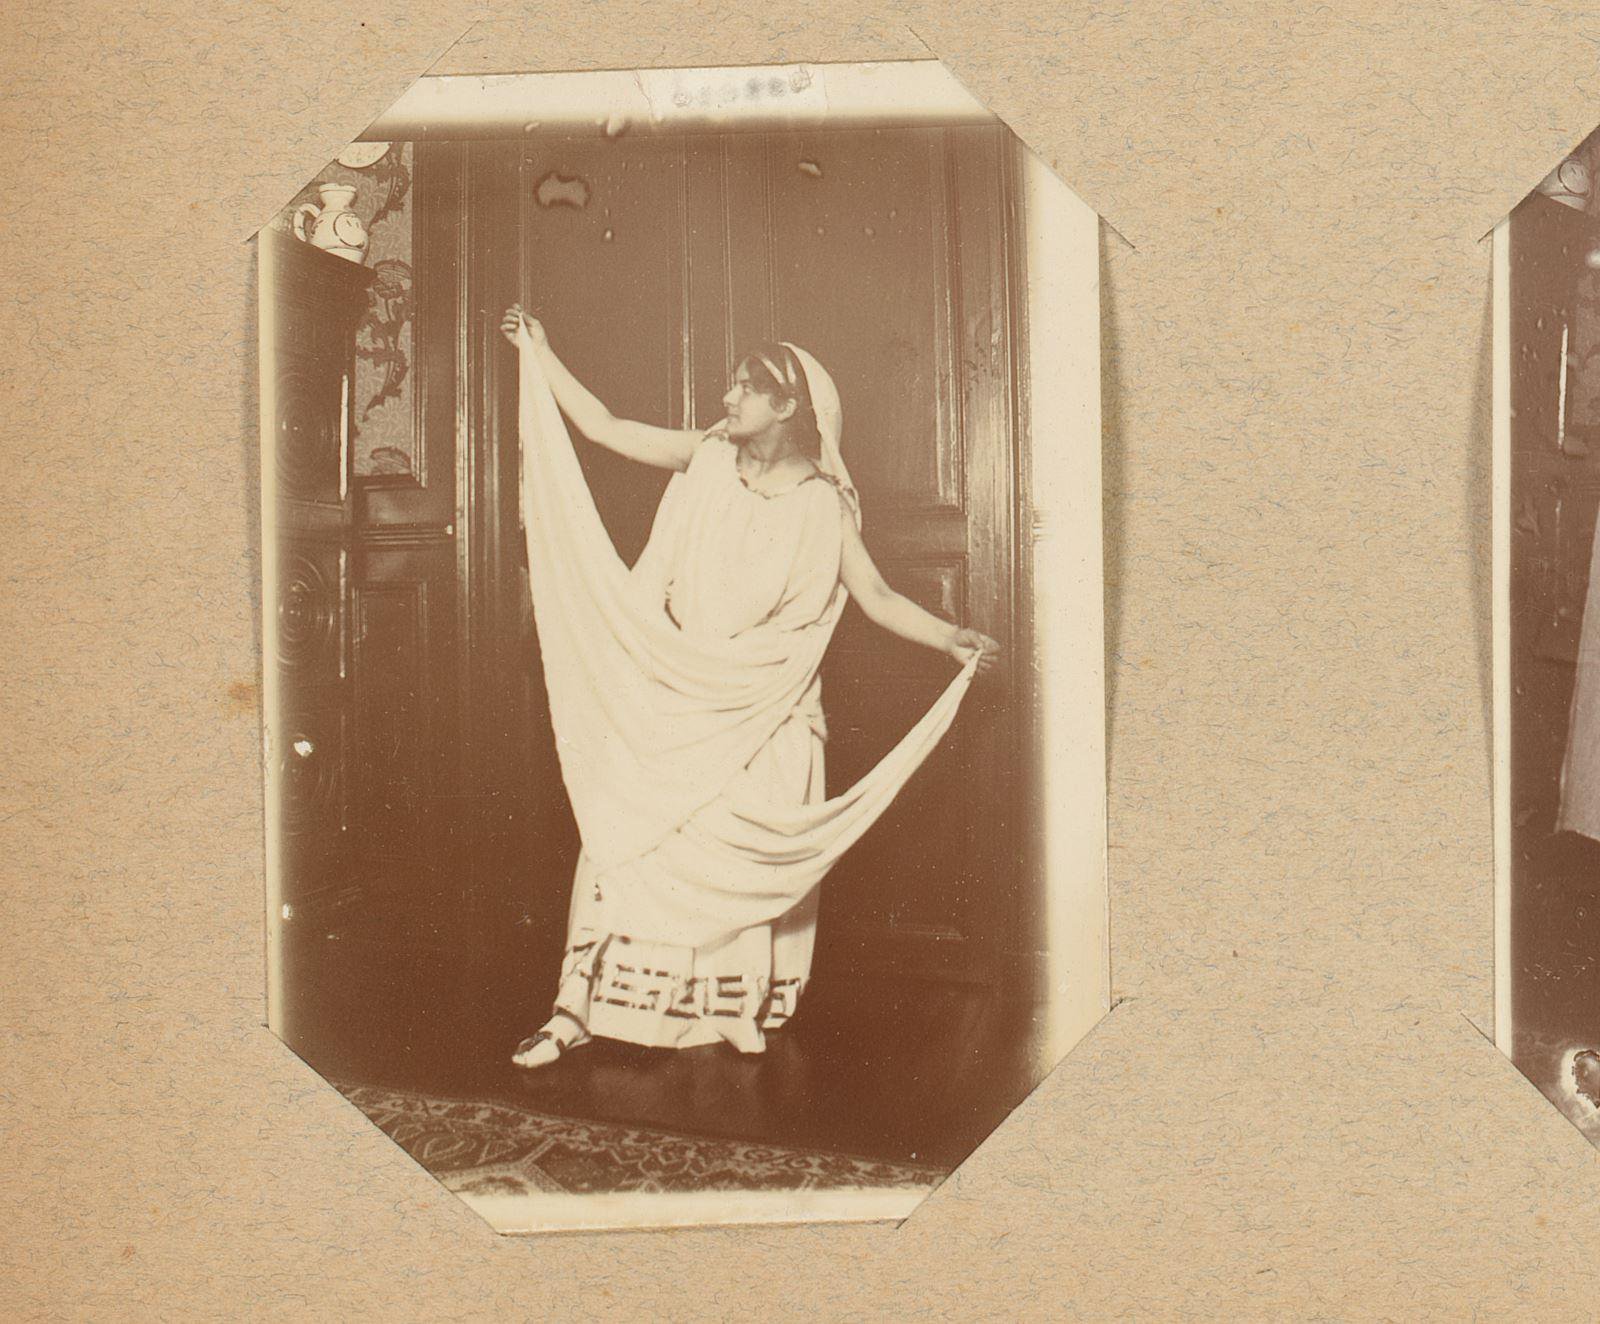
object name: photograph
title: Portret van een vrouw in verkleedkleding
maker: Anonymous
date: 1897-1900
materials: paper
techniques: gelatin silver print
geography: france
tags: adult woman, historical persons, historical costume, france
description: Over de foto is een ander negatief afgedrukt van een voorstelling van bomen.